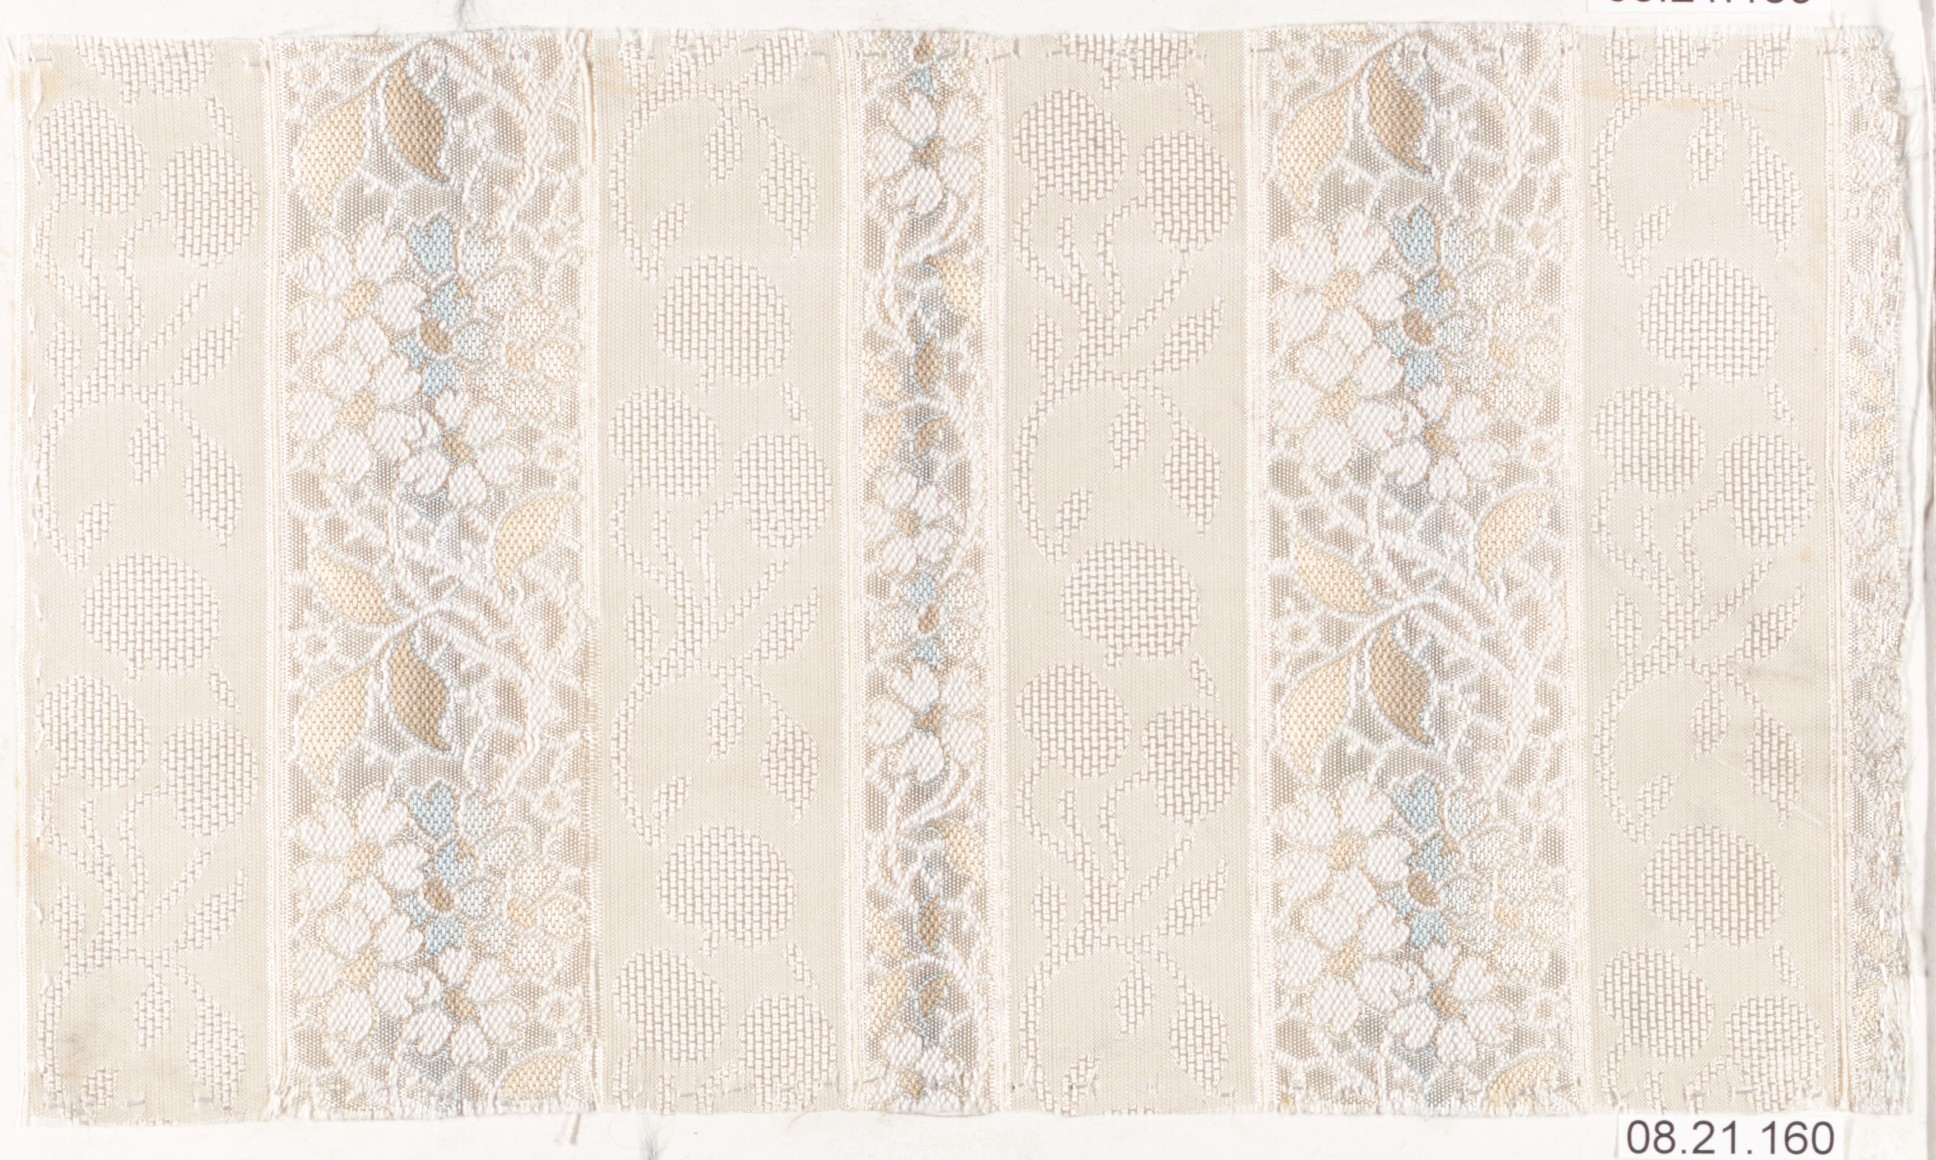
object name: textile sample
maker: Anonymous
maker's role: designer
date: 1900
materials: silk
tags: flowers